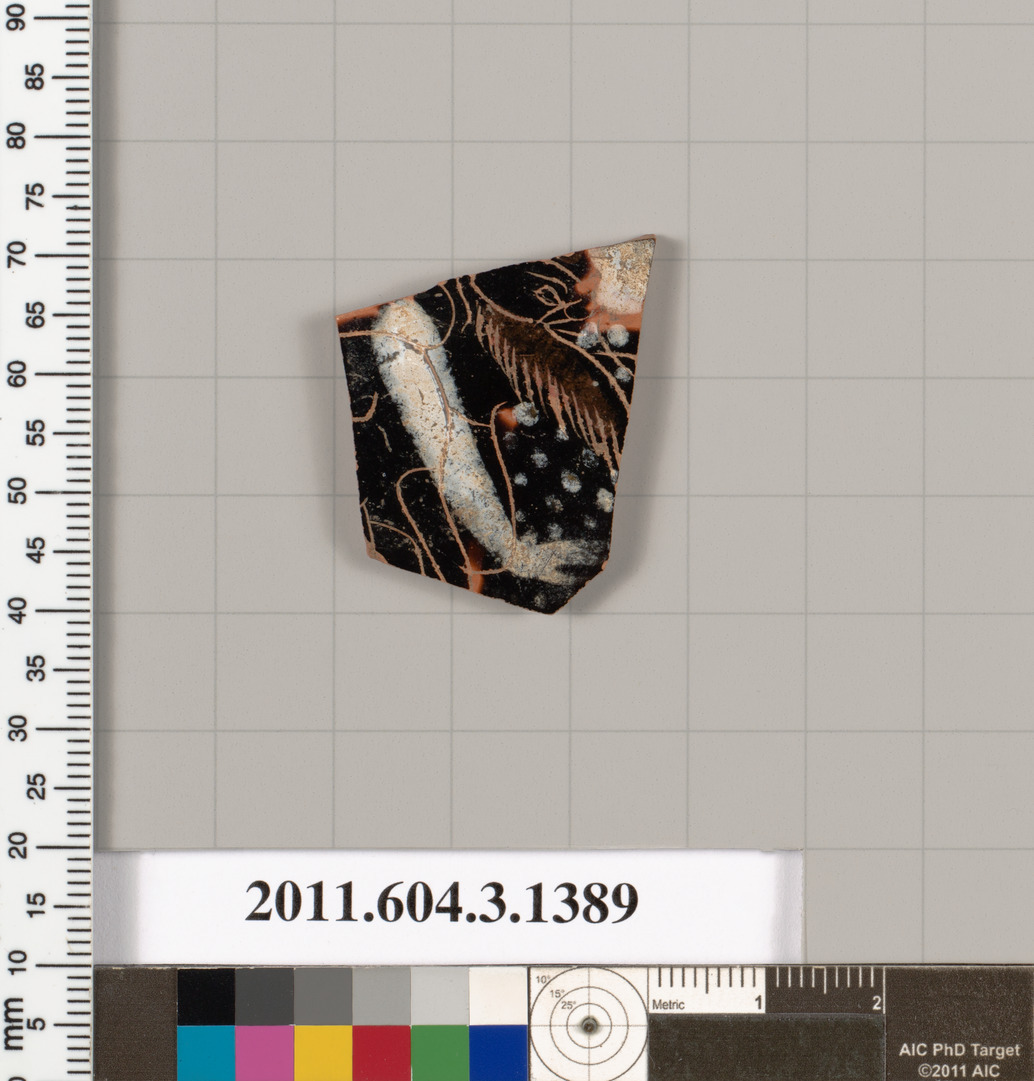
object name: skyphos fragment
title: Terracotta fragment of a skyphos (deep drinking cup)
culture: greek, attic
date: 534-468 BCE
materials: terracotta